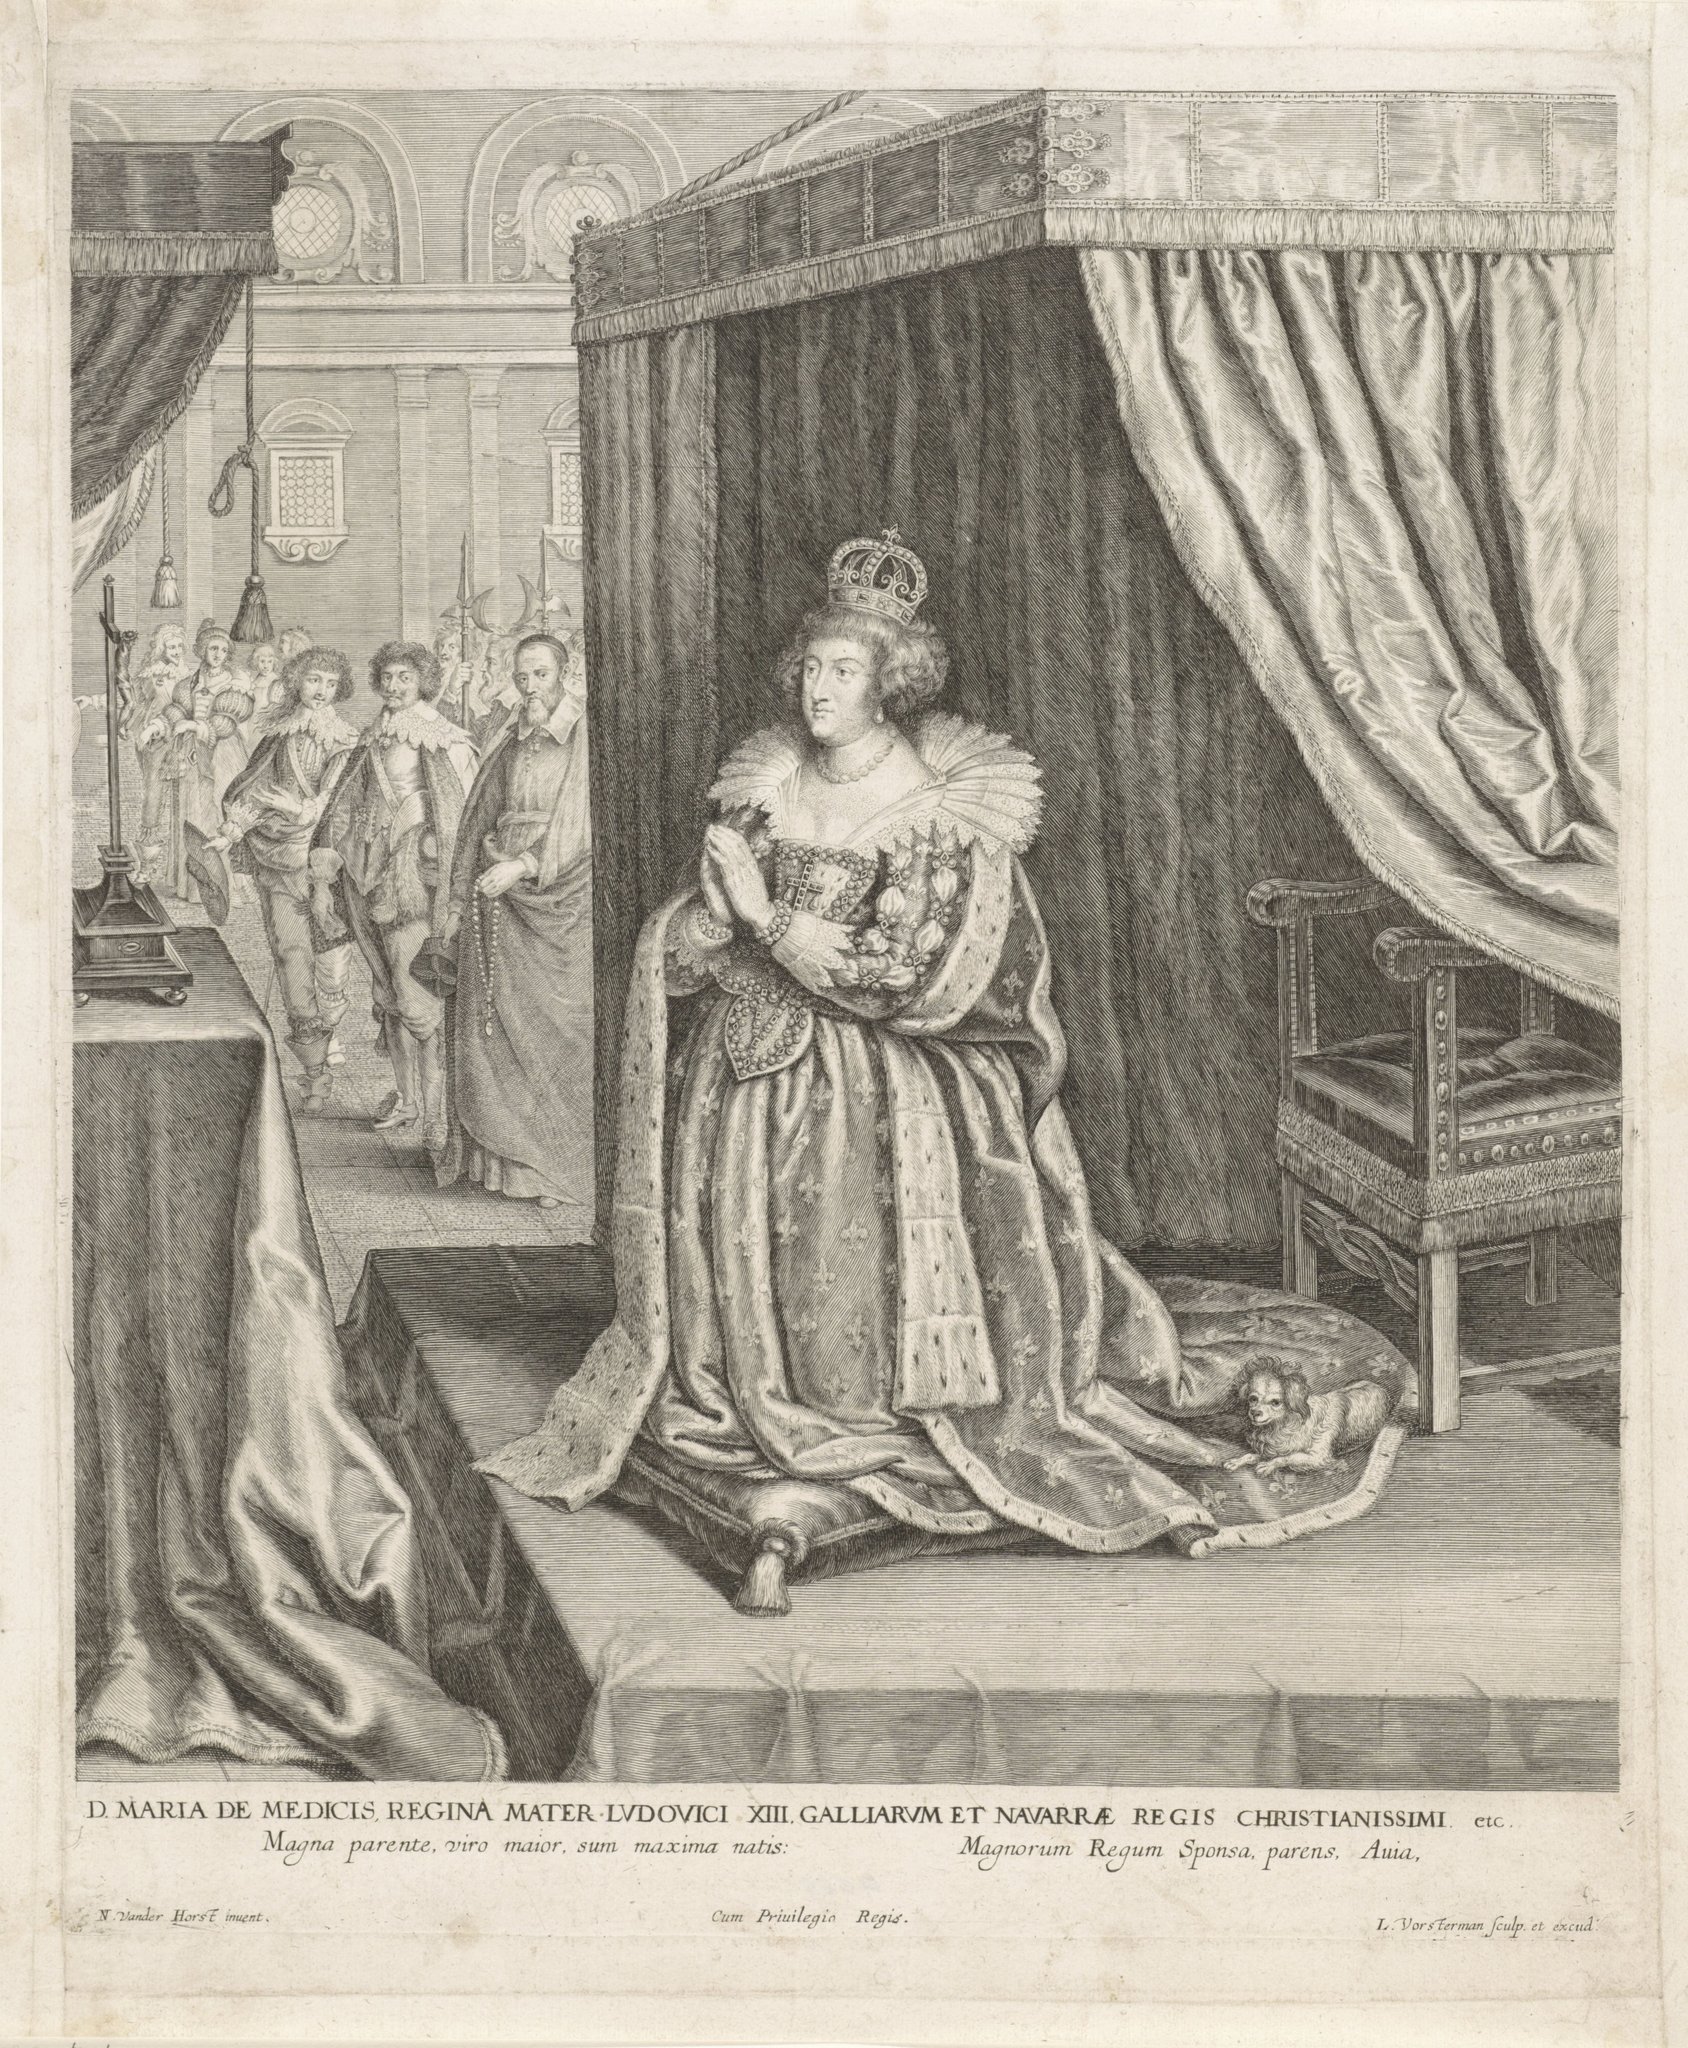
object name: print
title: Maria de' Medici knielend voor een crucifix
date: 1619-1675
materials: paper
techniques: engraving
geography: antwerp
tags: cologne, print maker, maria de' medici, altarcross, crucifix, kneeling on both knees - aa - female human figure, one person praying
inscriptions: signature: ‘Lucas Vorsterman sculp. et excud.’, caption: ‘D. Maria de Medicis, Regina Mater Ludovici XIII...parens, Avia.’, signature: ‘N. Vander Horst invent.’, collector's mark: Lugt 2228, privilege: ‘Cum Privilegio Regis’